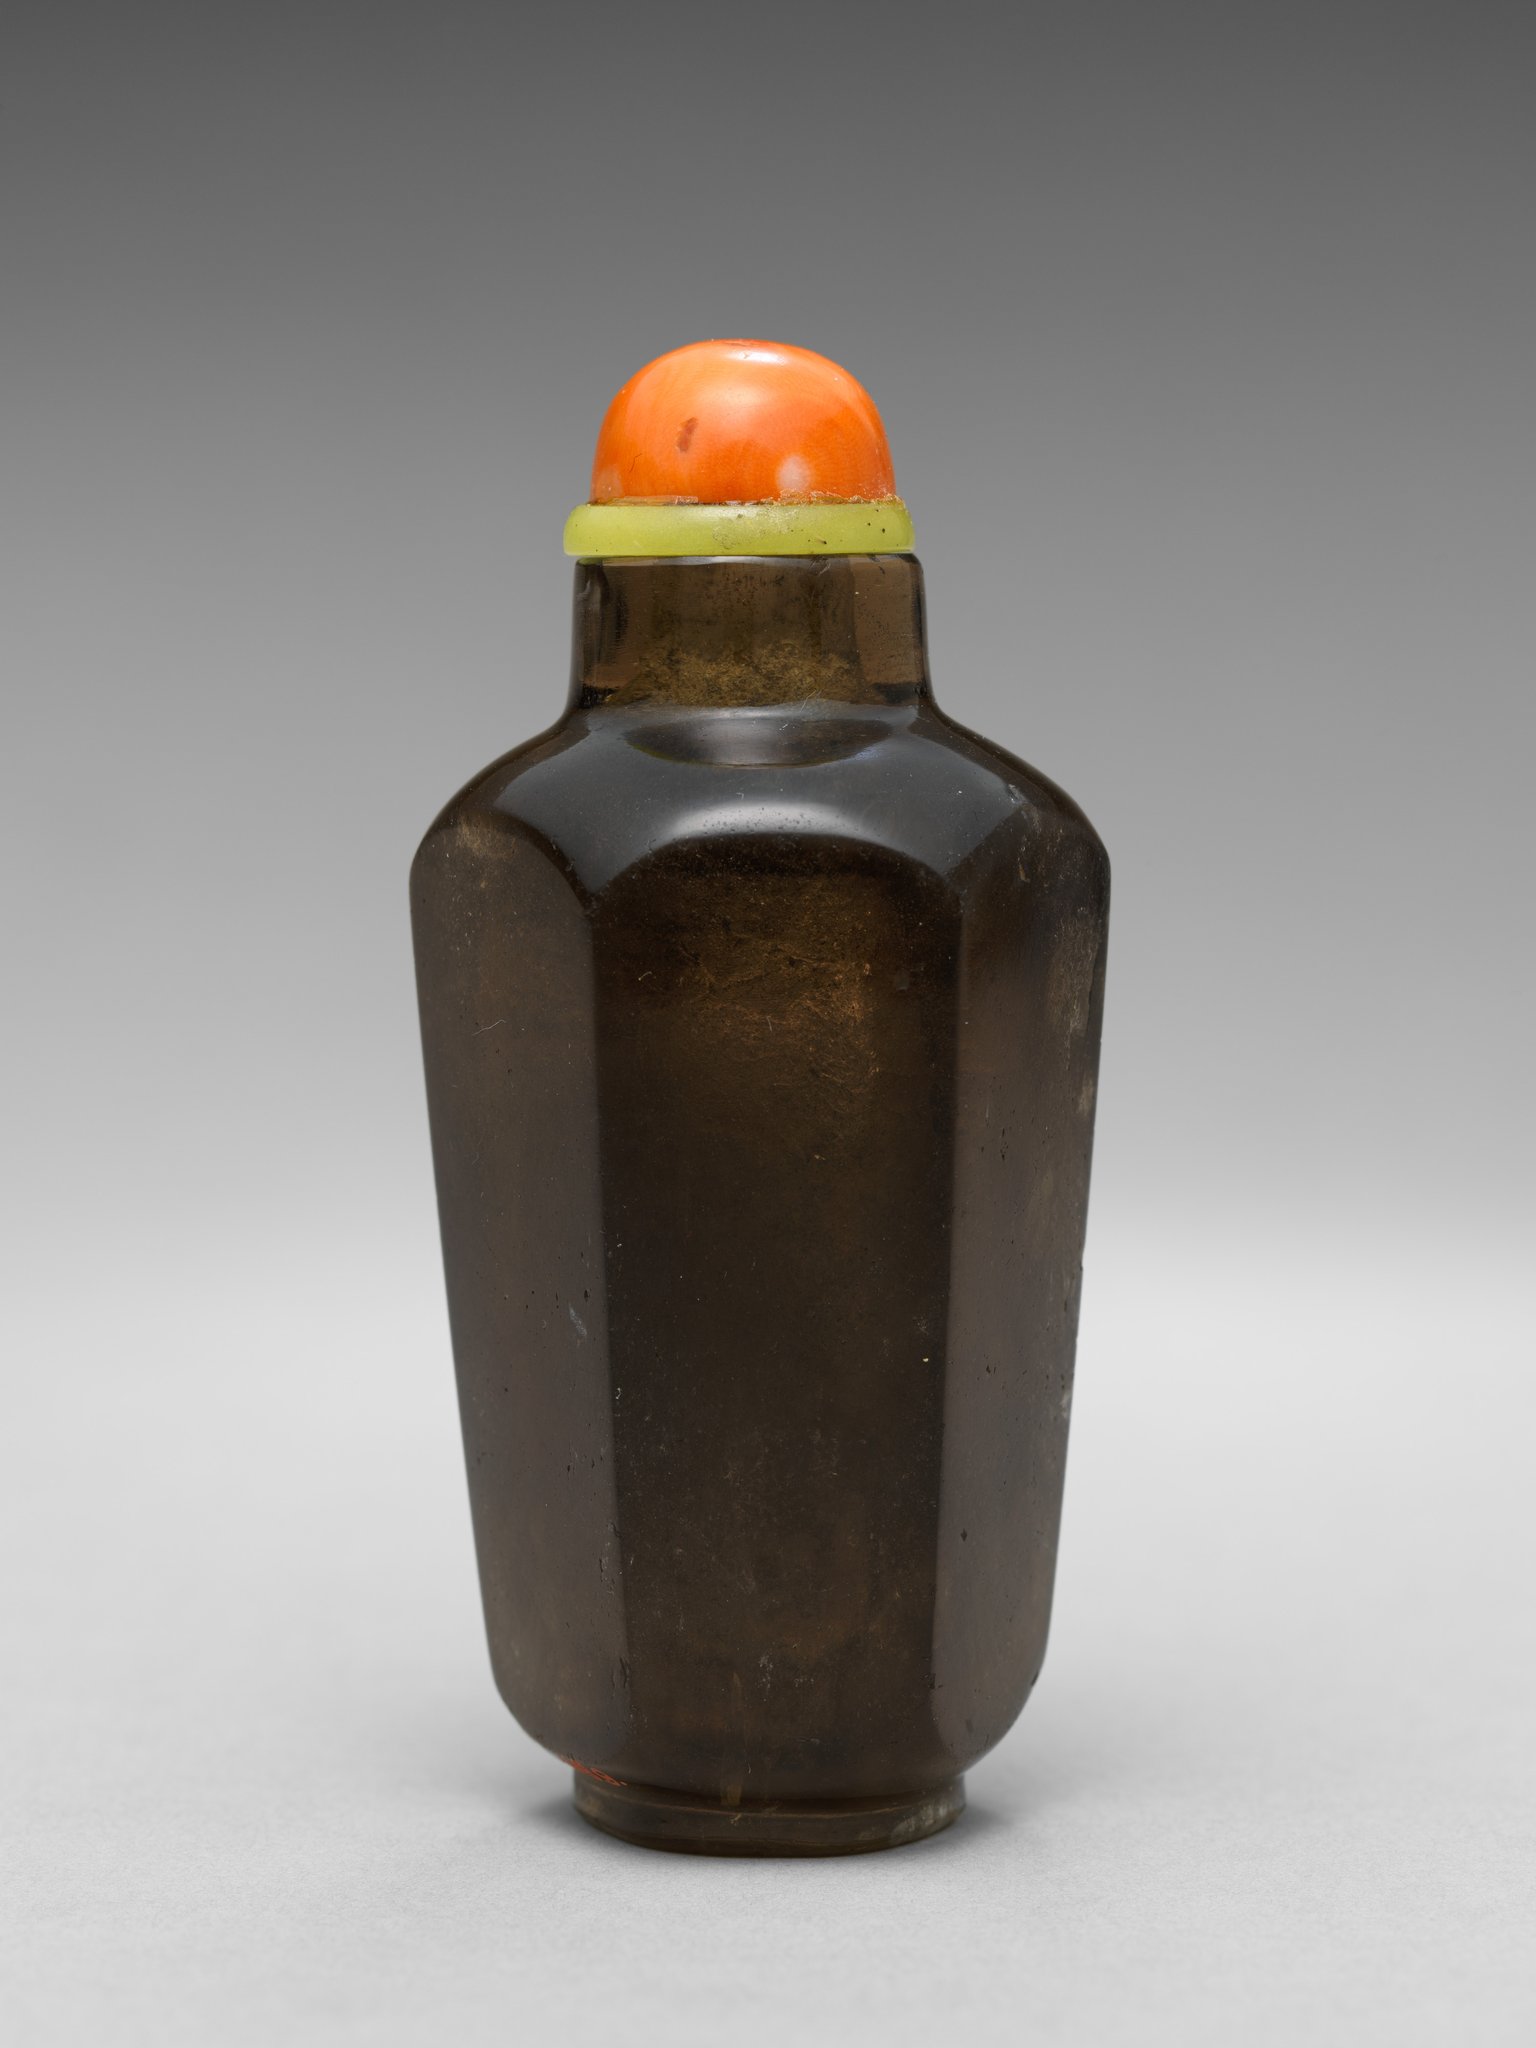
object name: snuff bottle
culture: chinese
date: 1801-1833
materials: coral, glass, quartz